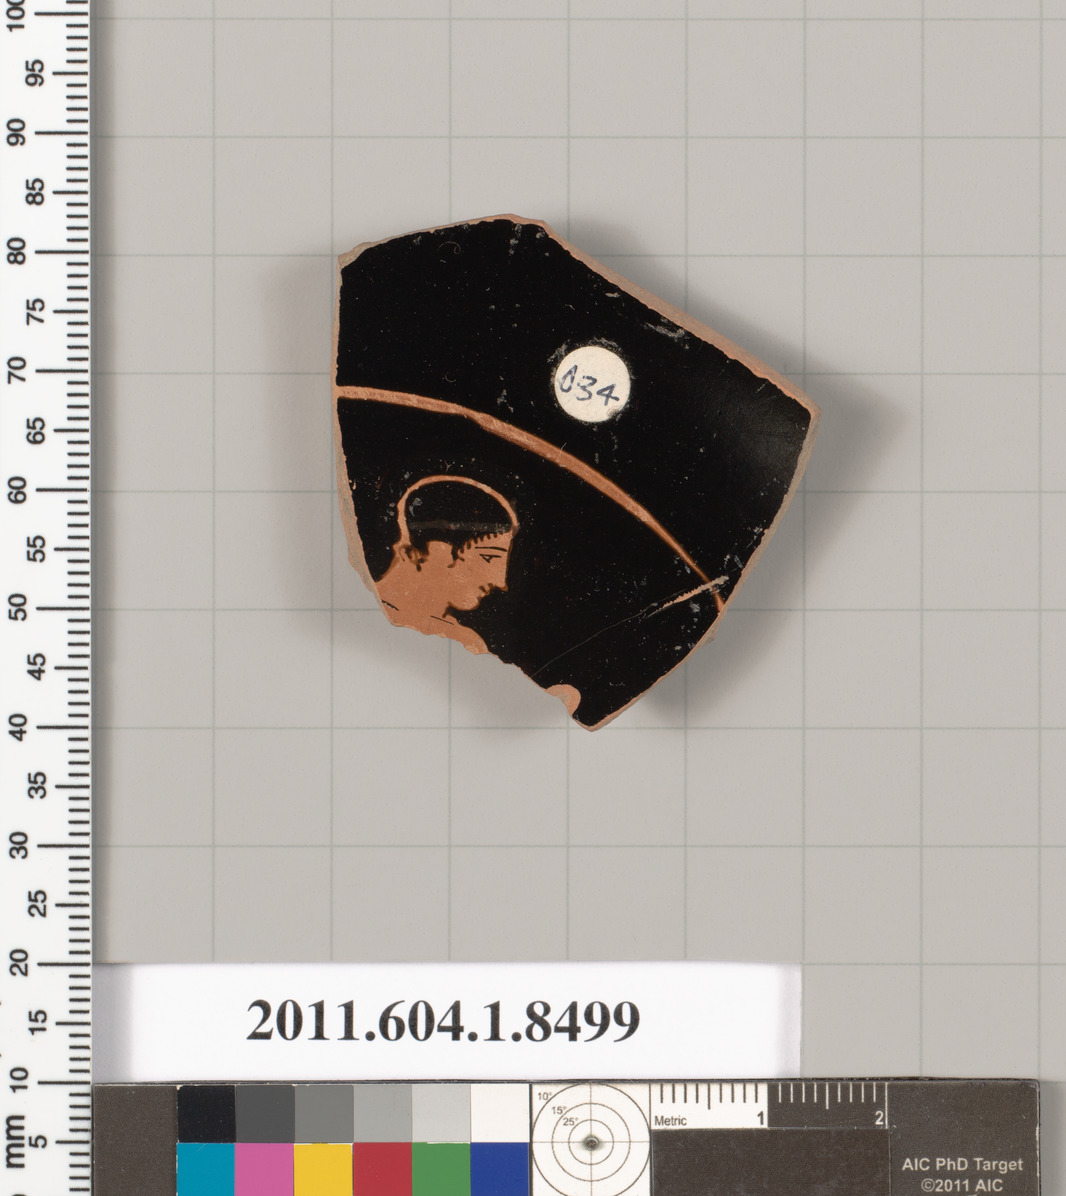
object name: kylix fragment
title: Terracotta fragment of a stemless kylix (drinking cup)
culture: greek, attic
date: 460-450 BCE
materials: terracotta